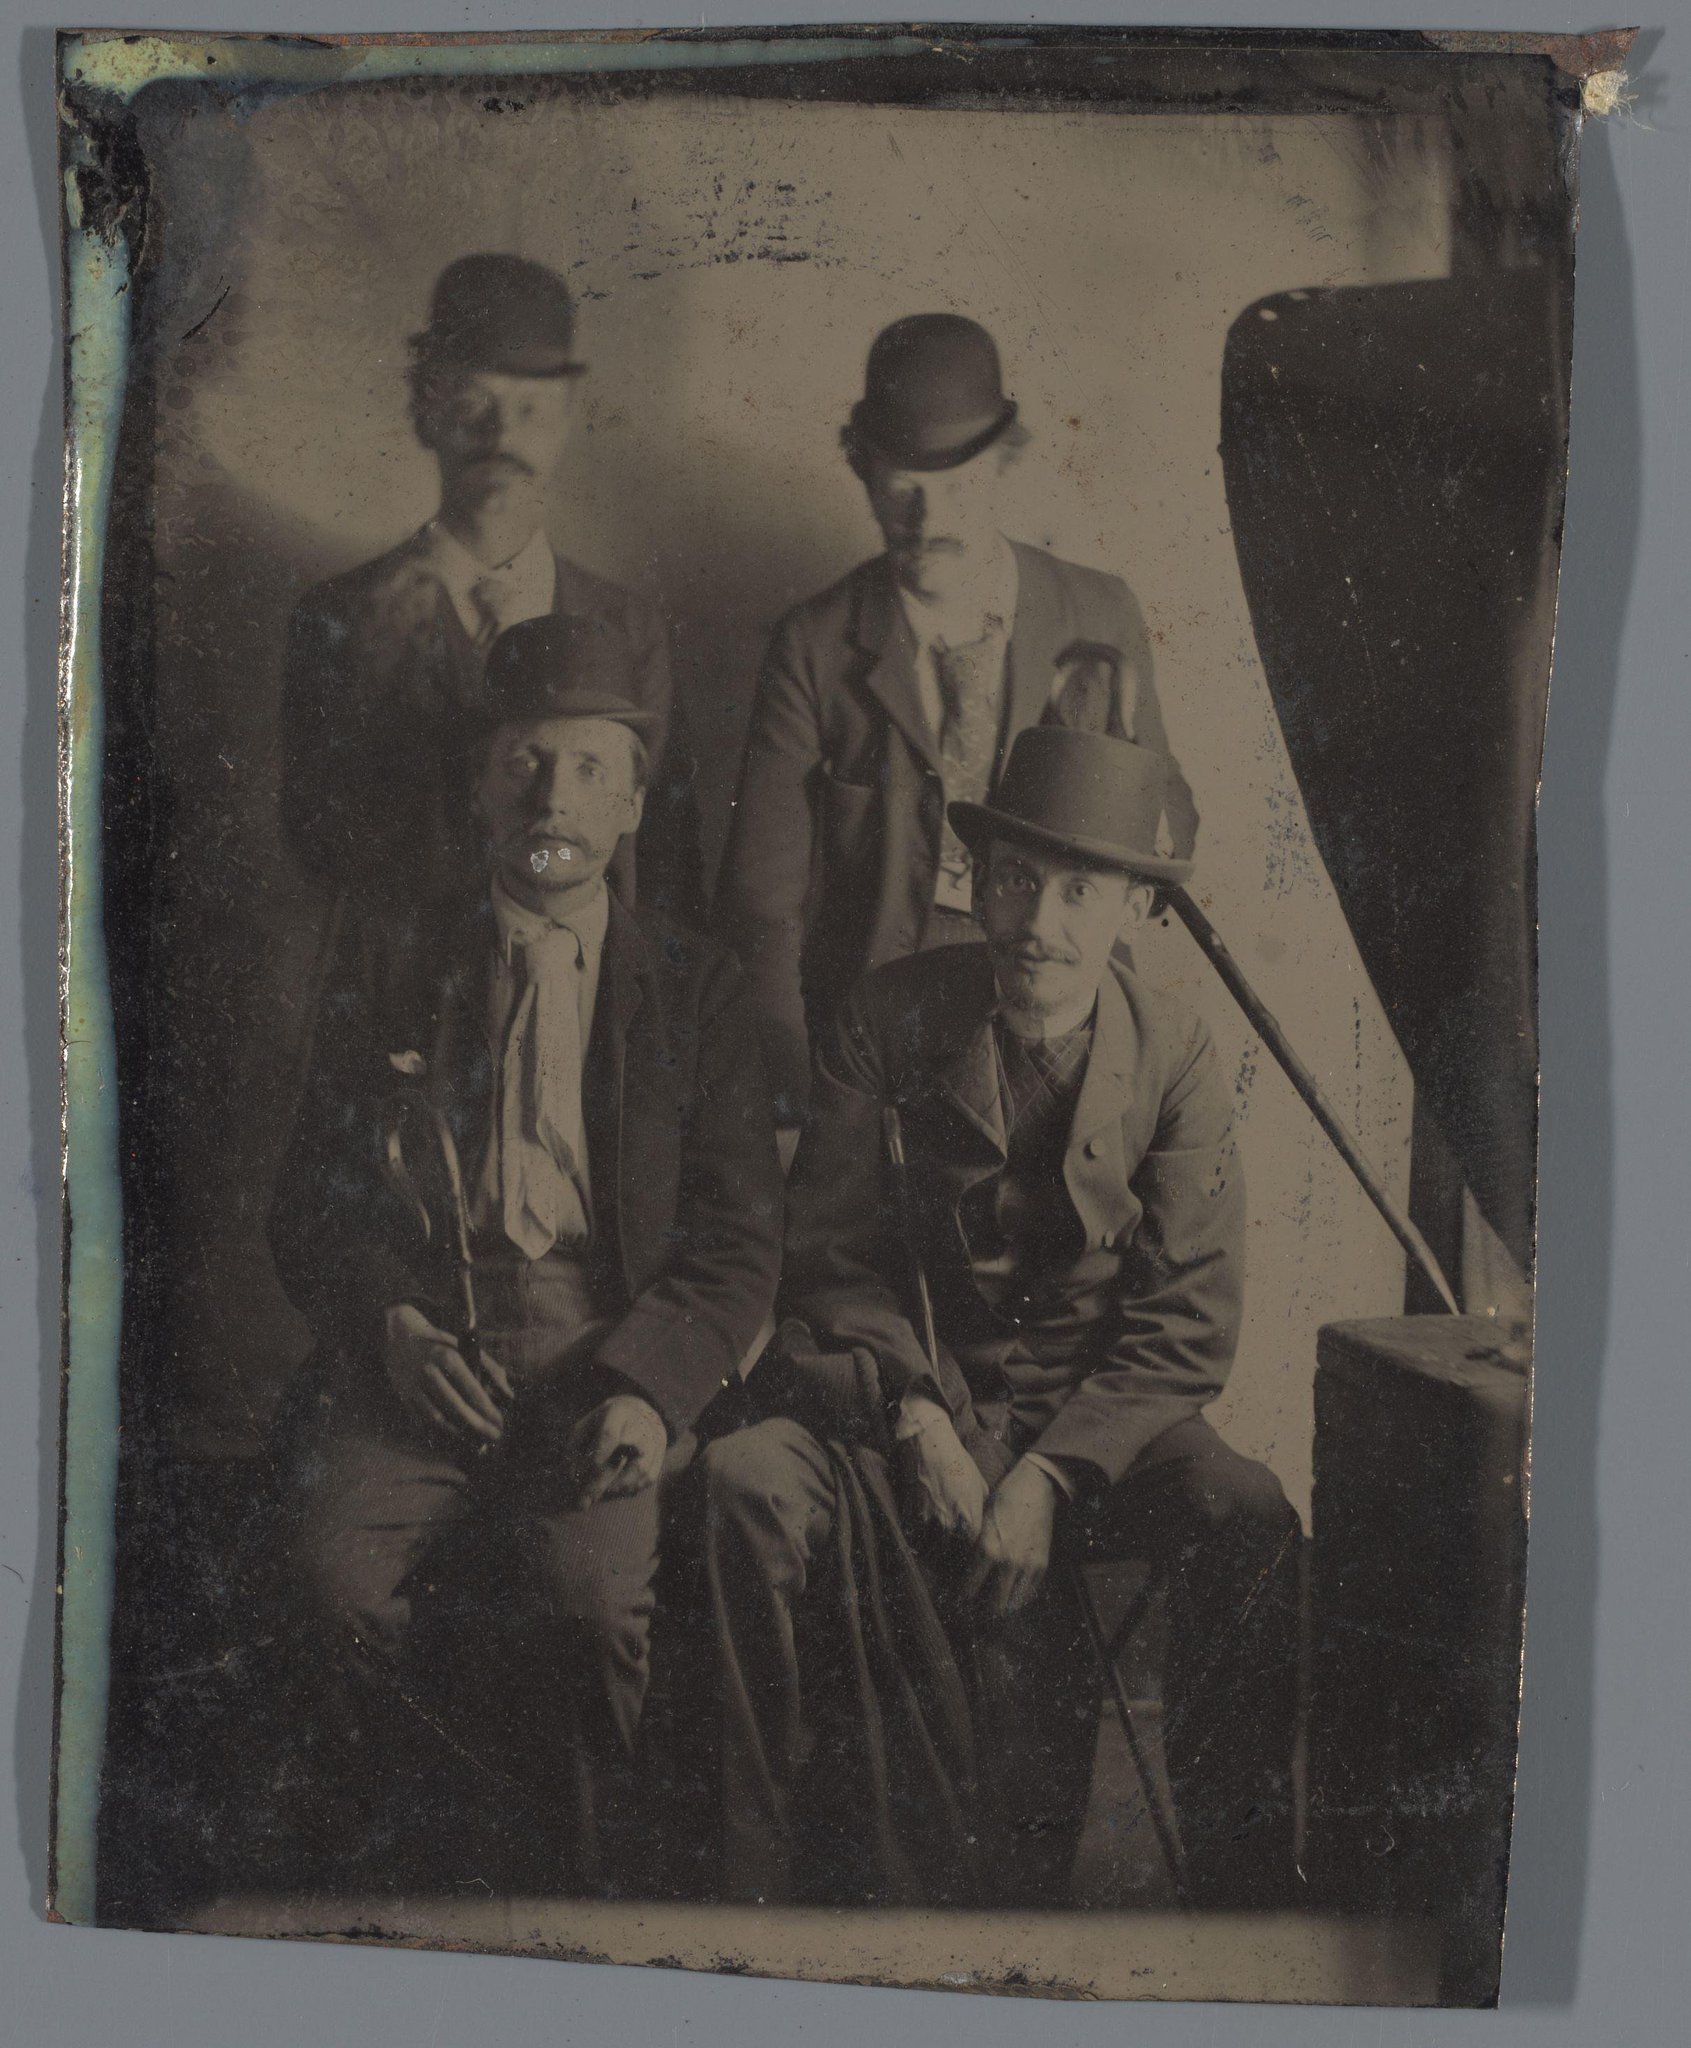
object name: photograph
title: Groepsportret met Alphons Diepenbrock, Hein Boeken, Willem Kloos en rechtsvoor een onbekende jongeman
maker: Anonymous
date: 1885-1890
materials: iron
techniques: ferrotyping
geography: netherlands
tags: the hague, willem kloos, amsterdam, hein boeken, alphons diepenbrock, historical persons, head-gear: hat